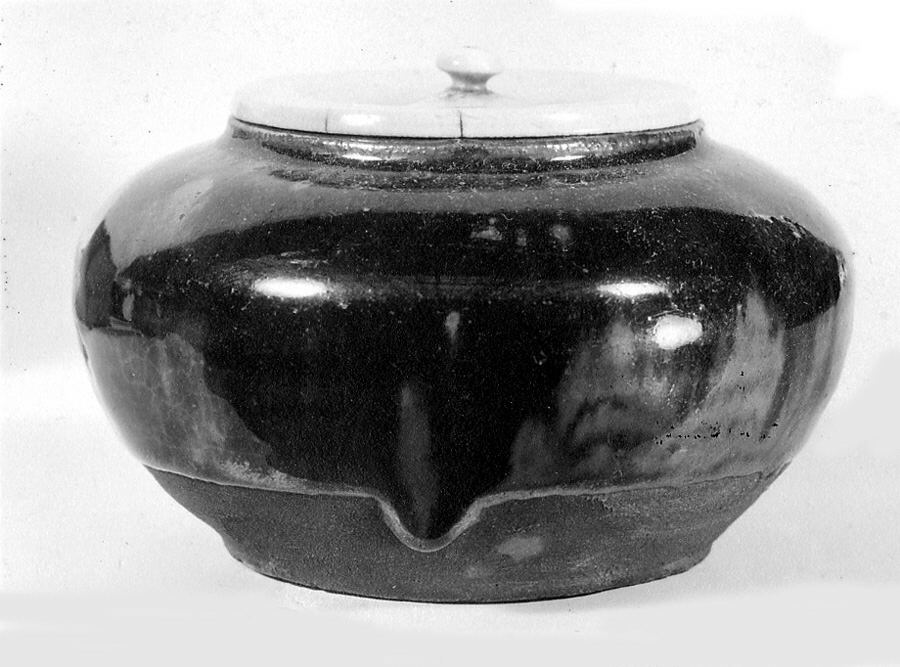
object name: tea jar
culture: japanese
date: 1701-1800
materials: clay, glaze